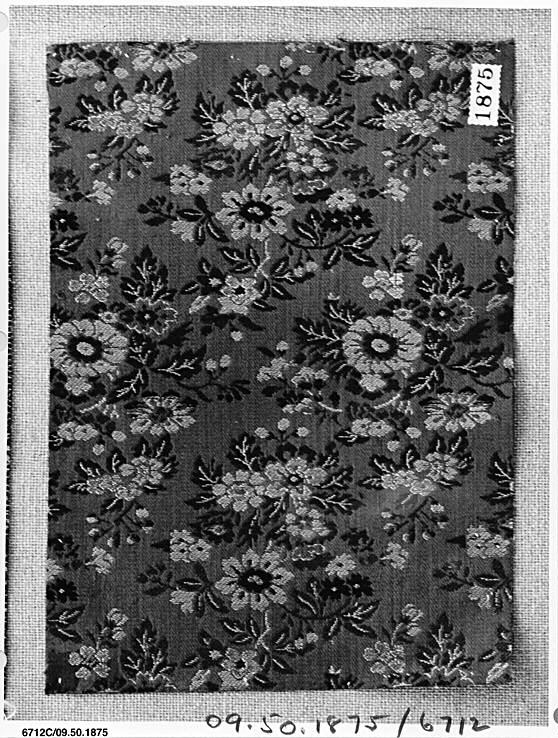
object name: piece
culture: japanese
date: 1801-1900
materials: silk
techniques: brocade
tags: leaves